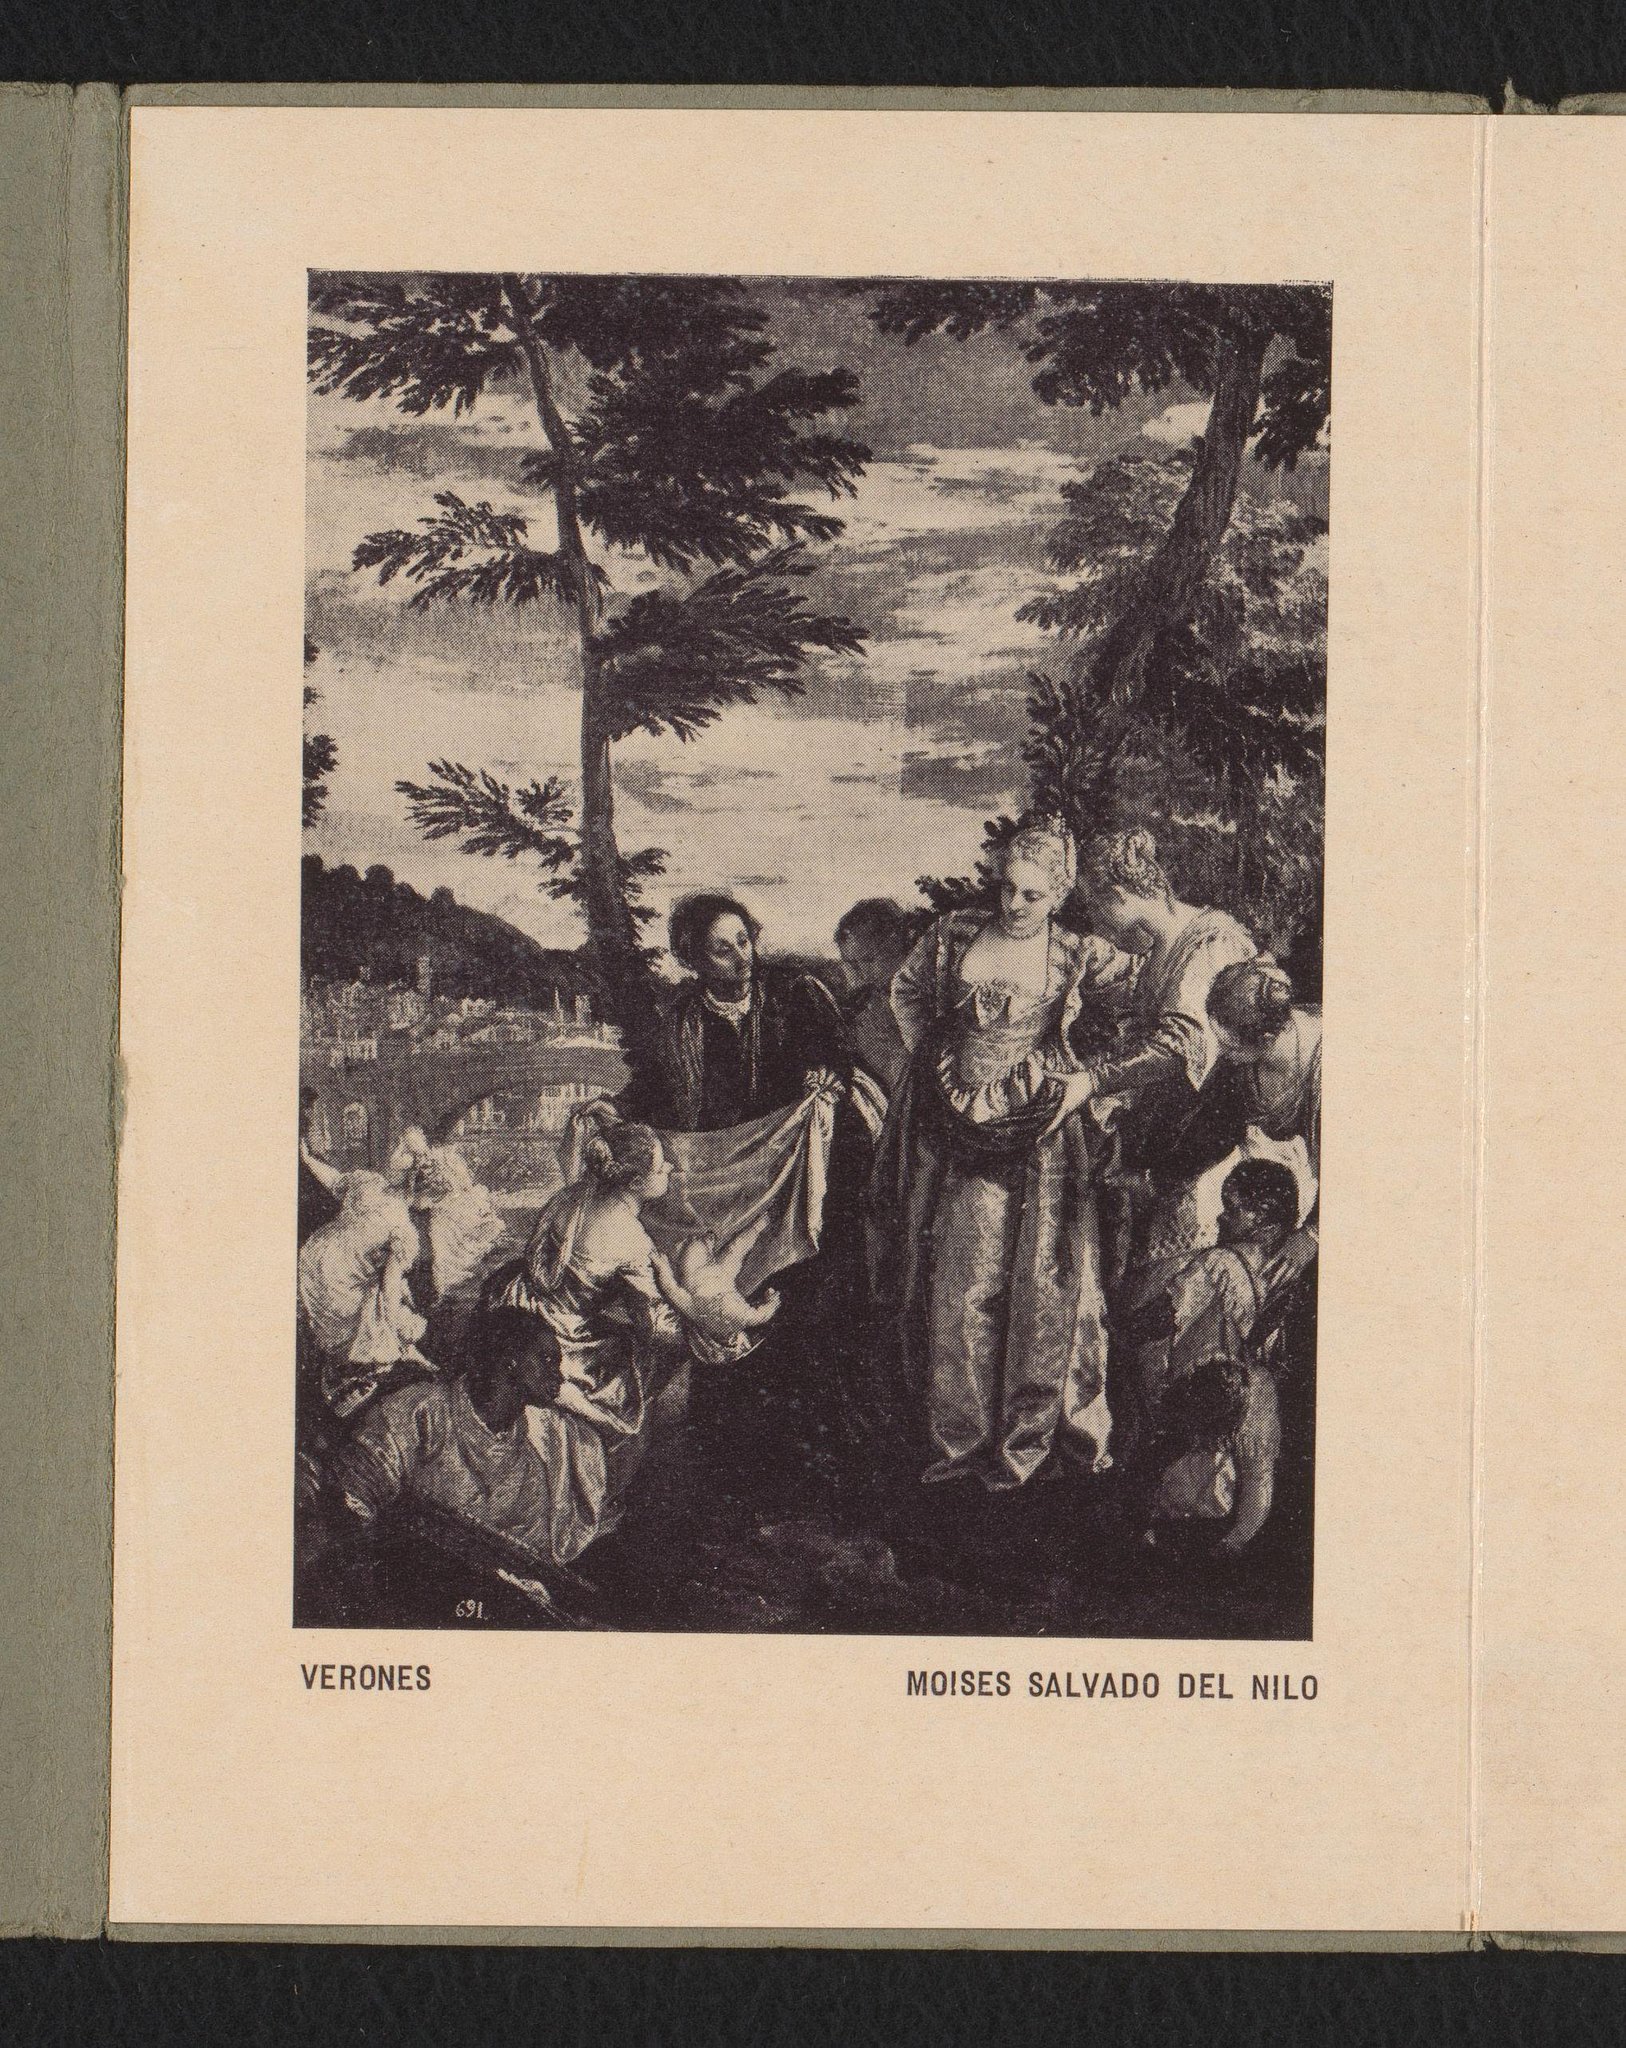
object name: photomechanical print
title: Verones. Moises Salvado del Nilo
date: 1910-1950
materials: cardboard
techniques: autotype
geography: madrid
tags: permanent exhibition, museum, picture, painting